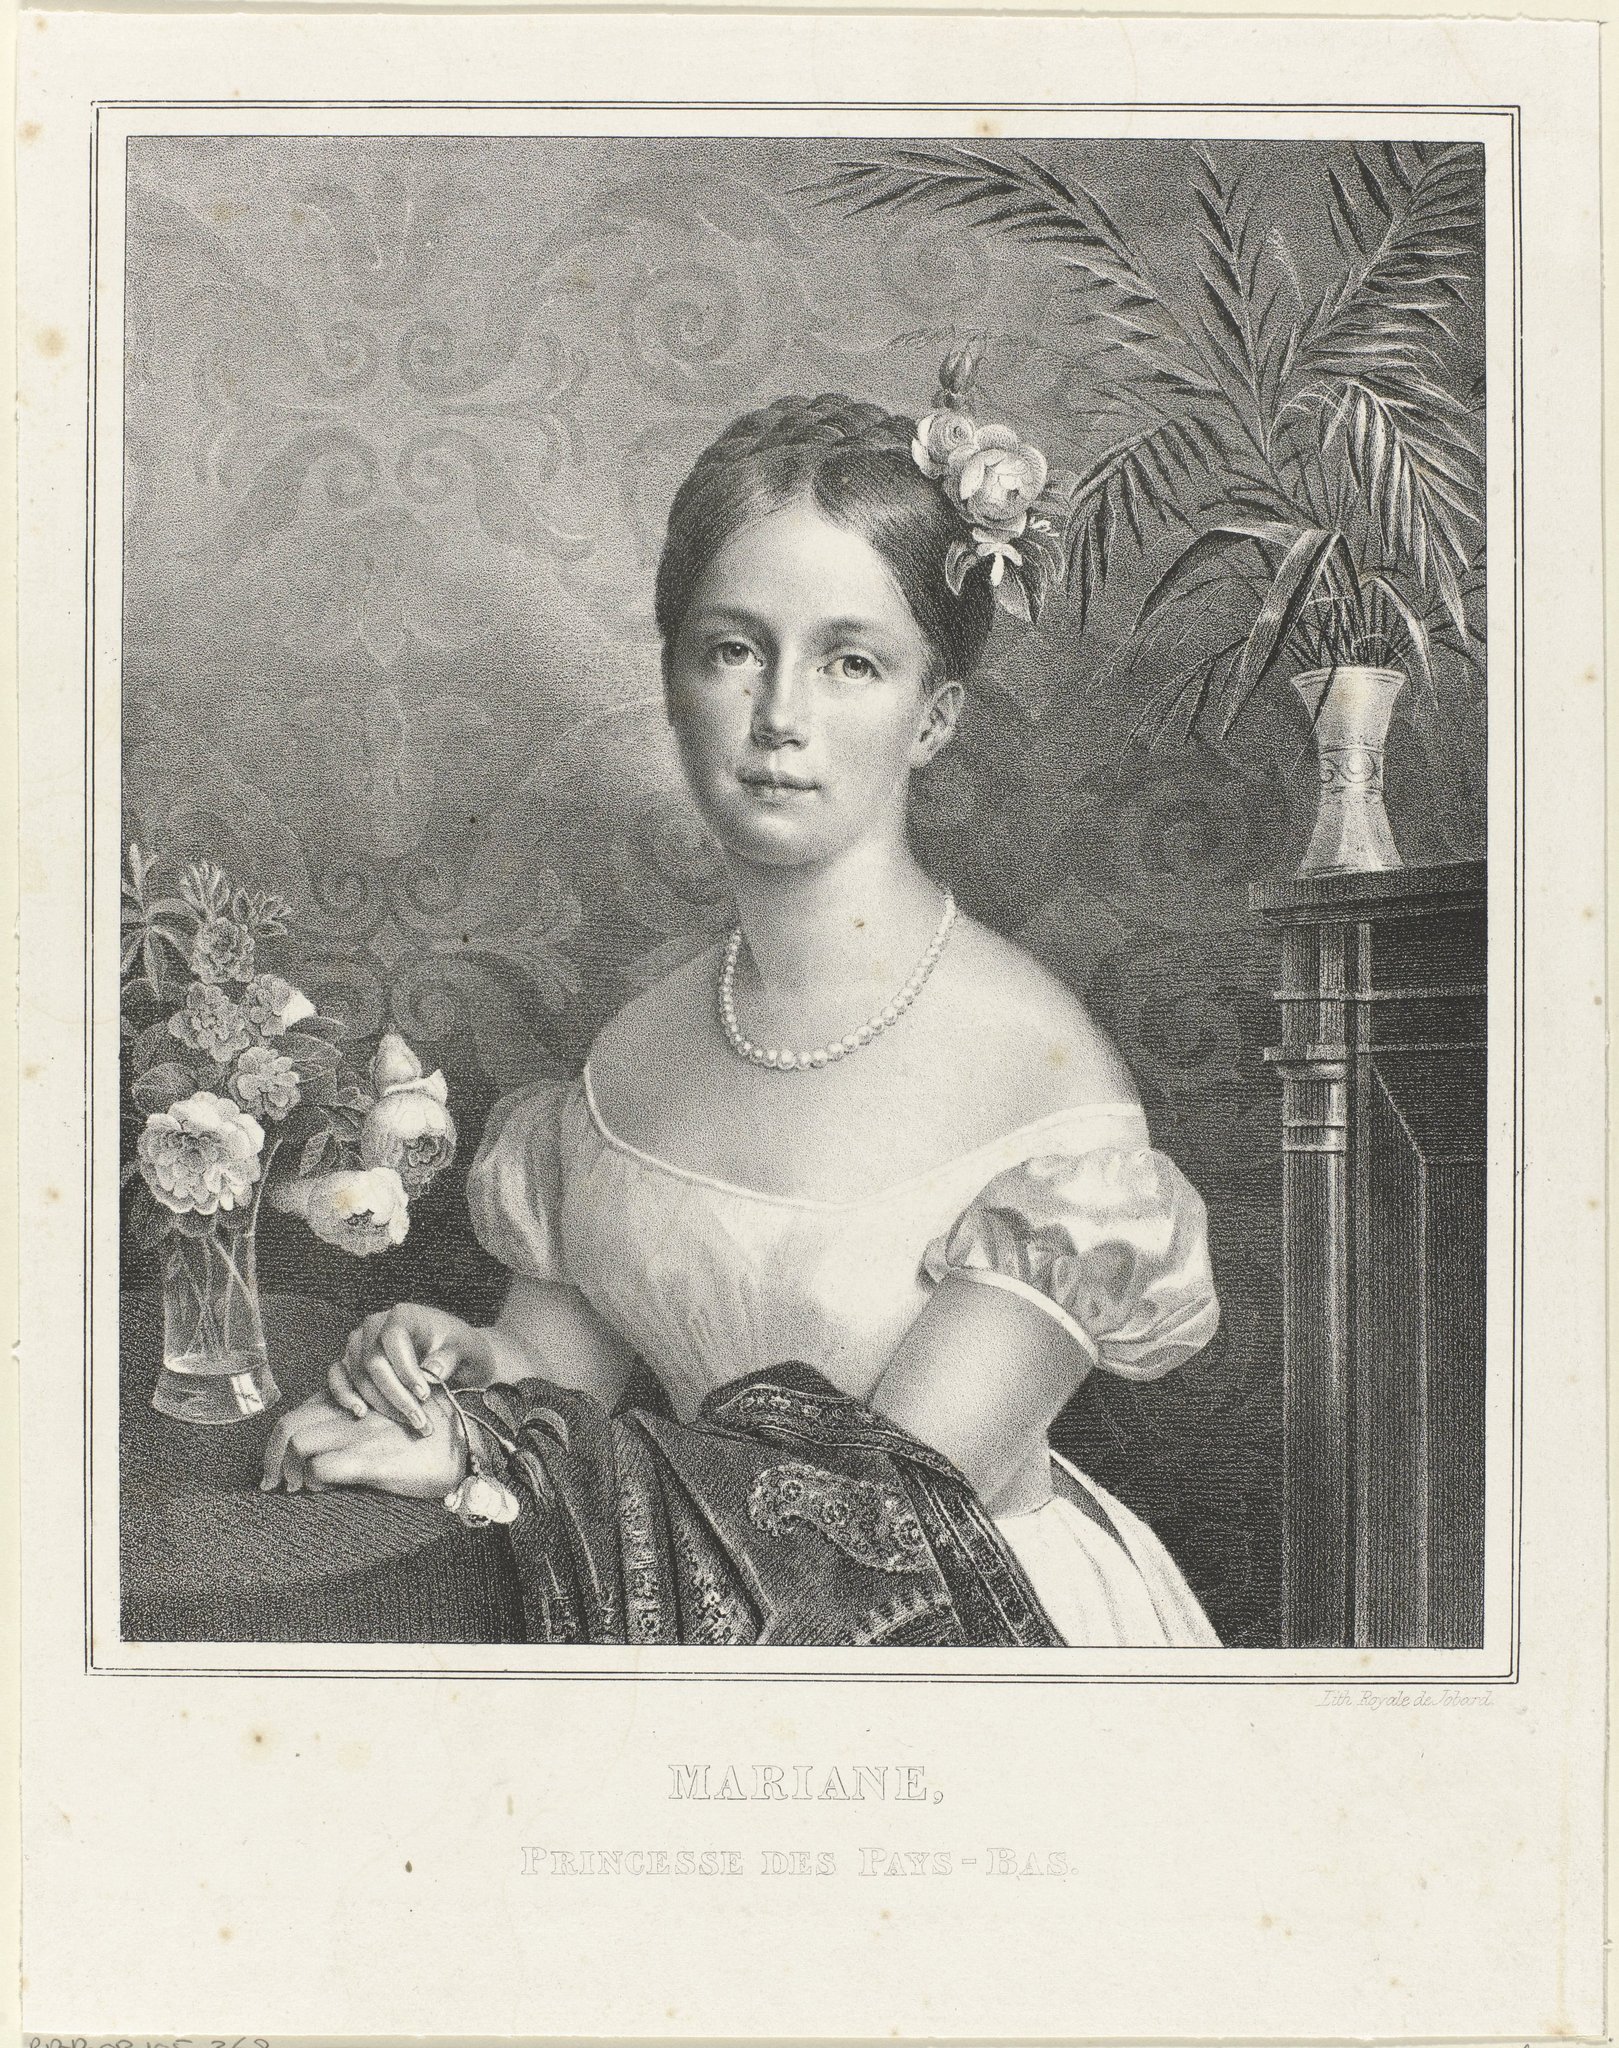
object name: print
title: Portret van Marianne, prinses der Nederlanden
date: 1825-1861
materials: paper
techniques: lithograph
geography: brussels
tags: berlin, voorburg, marianne (prinses der nederlanden)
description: De hier vermelde titel verwijst naar de hoogst verkregen titel van de geportretteerde, niet per se naar de titel die de geportretteerde op deze voorstelling draagt.